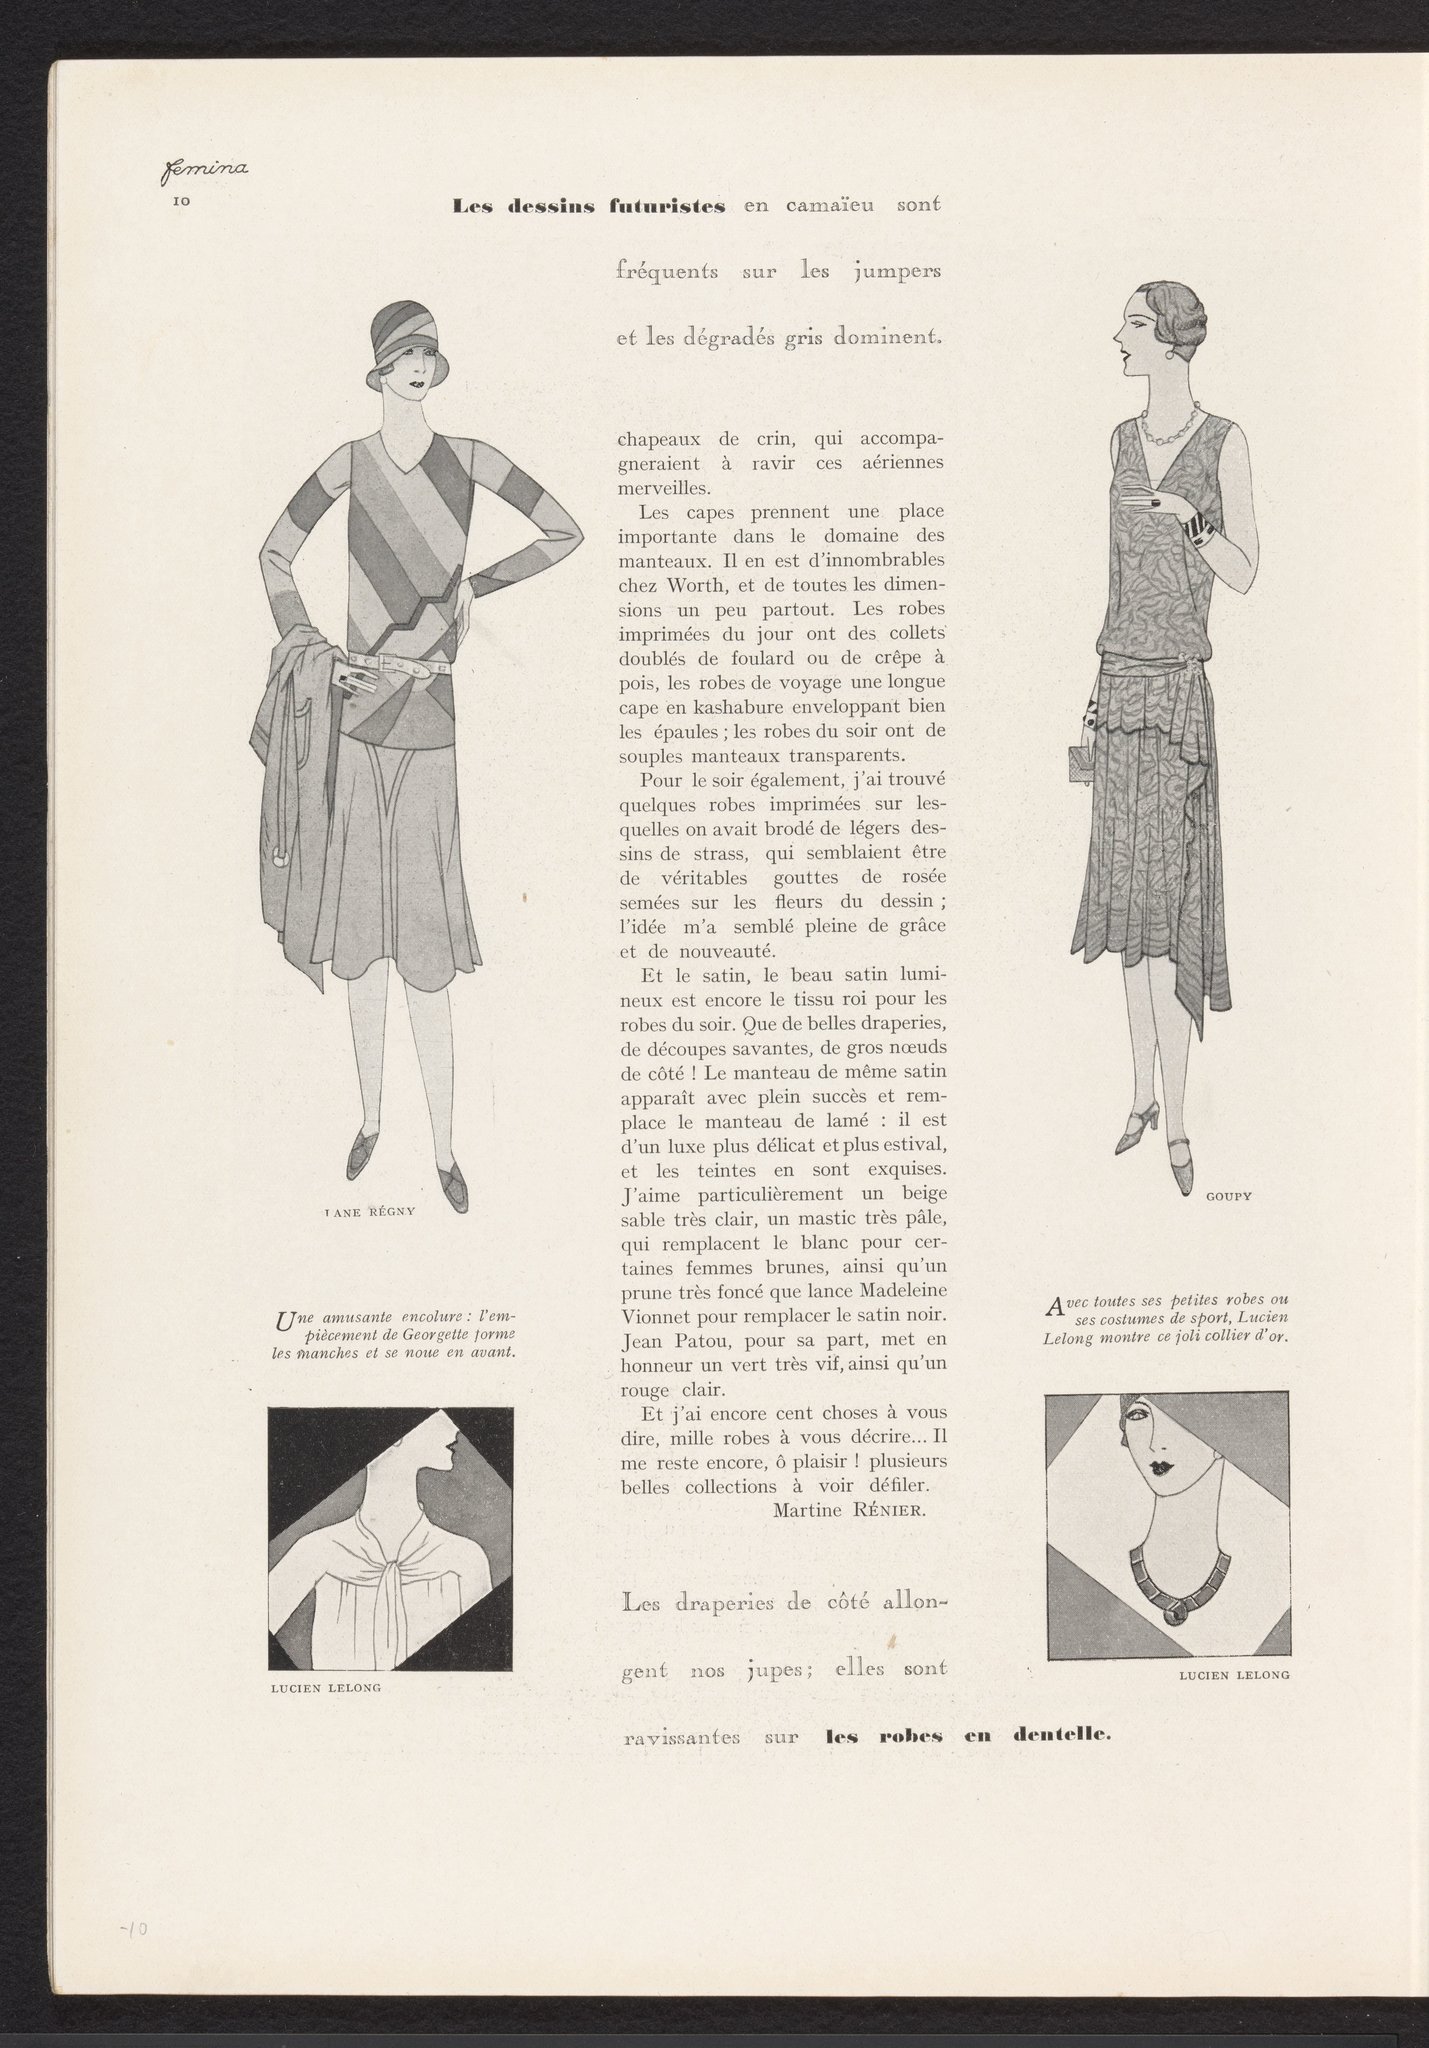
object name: fashion print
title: Femina, Mars 1928: 10: twee staande vrouwen in jurken van Jane Régny en Goupy en twee details van jurken van Lucien Lelong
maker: pierre laffitte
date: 1928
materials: paper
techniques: letterpress printing, photography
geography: paris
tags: fashion plates, standing figure - aa - female human figure, dress, gown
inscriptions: date